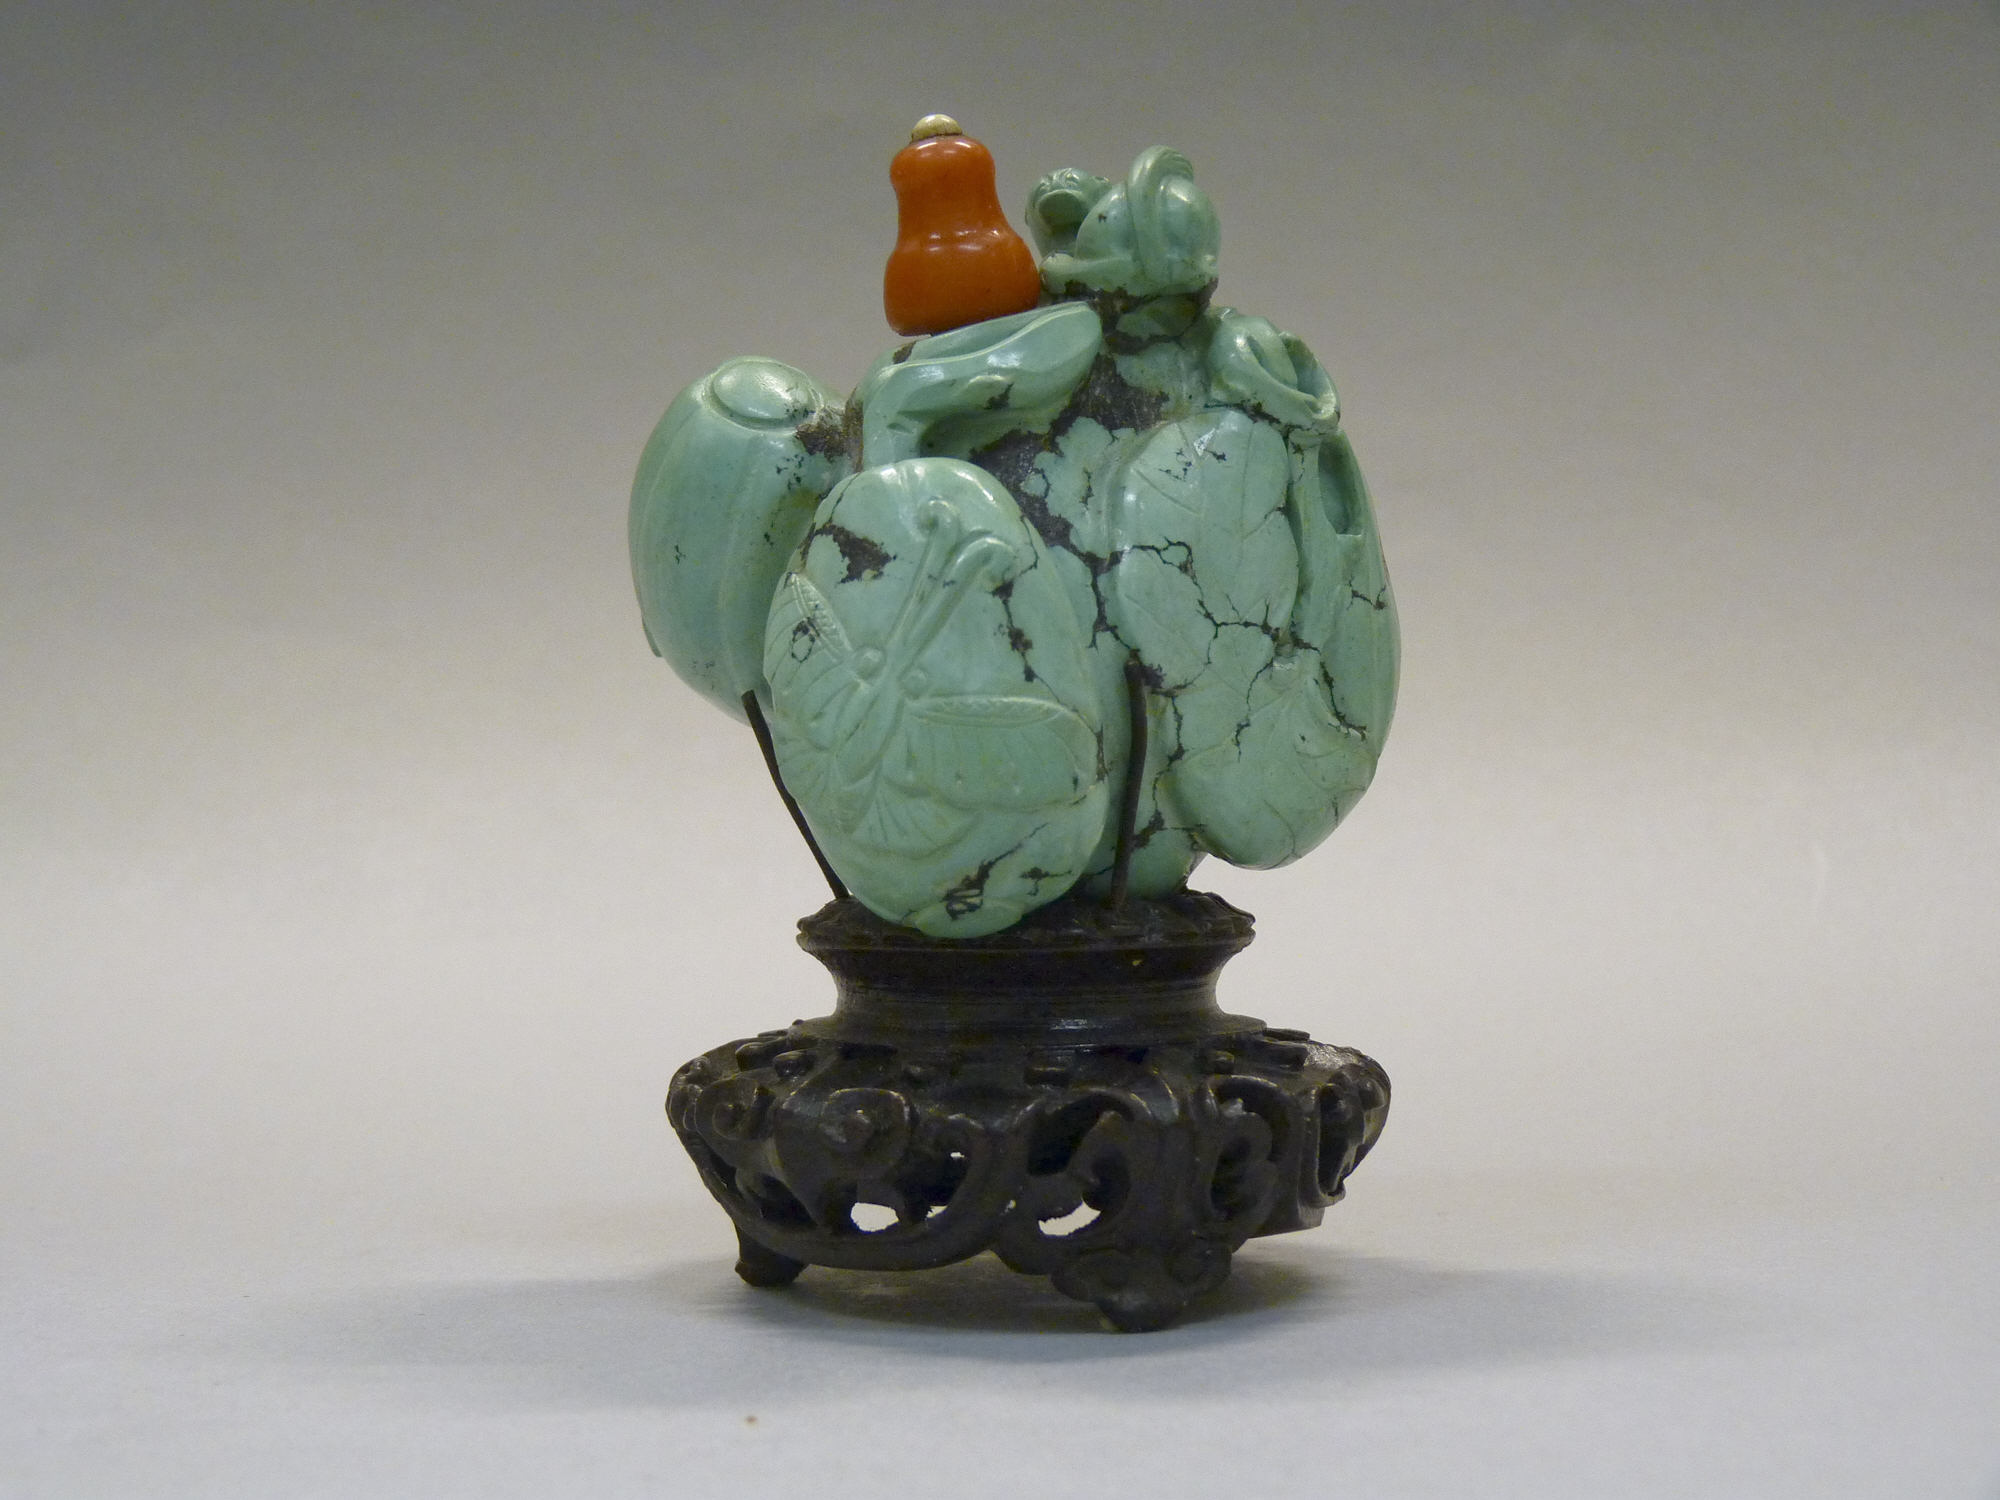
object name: snuff bottle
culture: chinese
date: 1736-1795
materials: glass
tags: insects